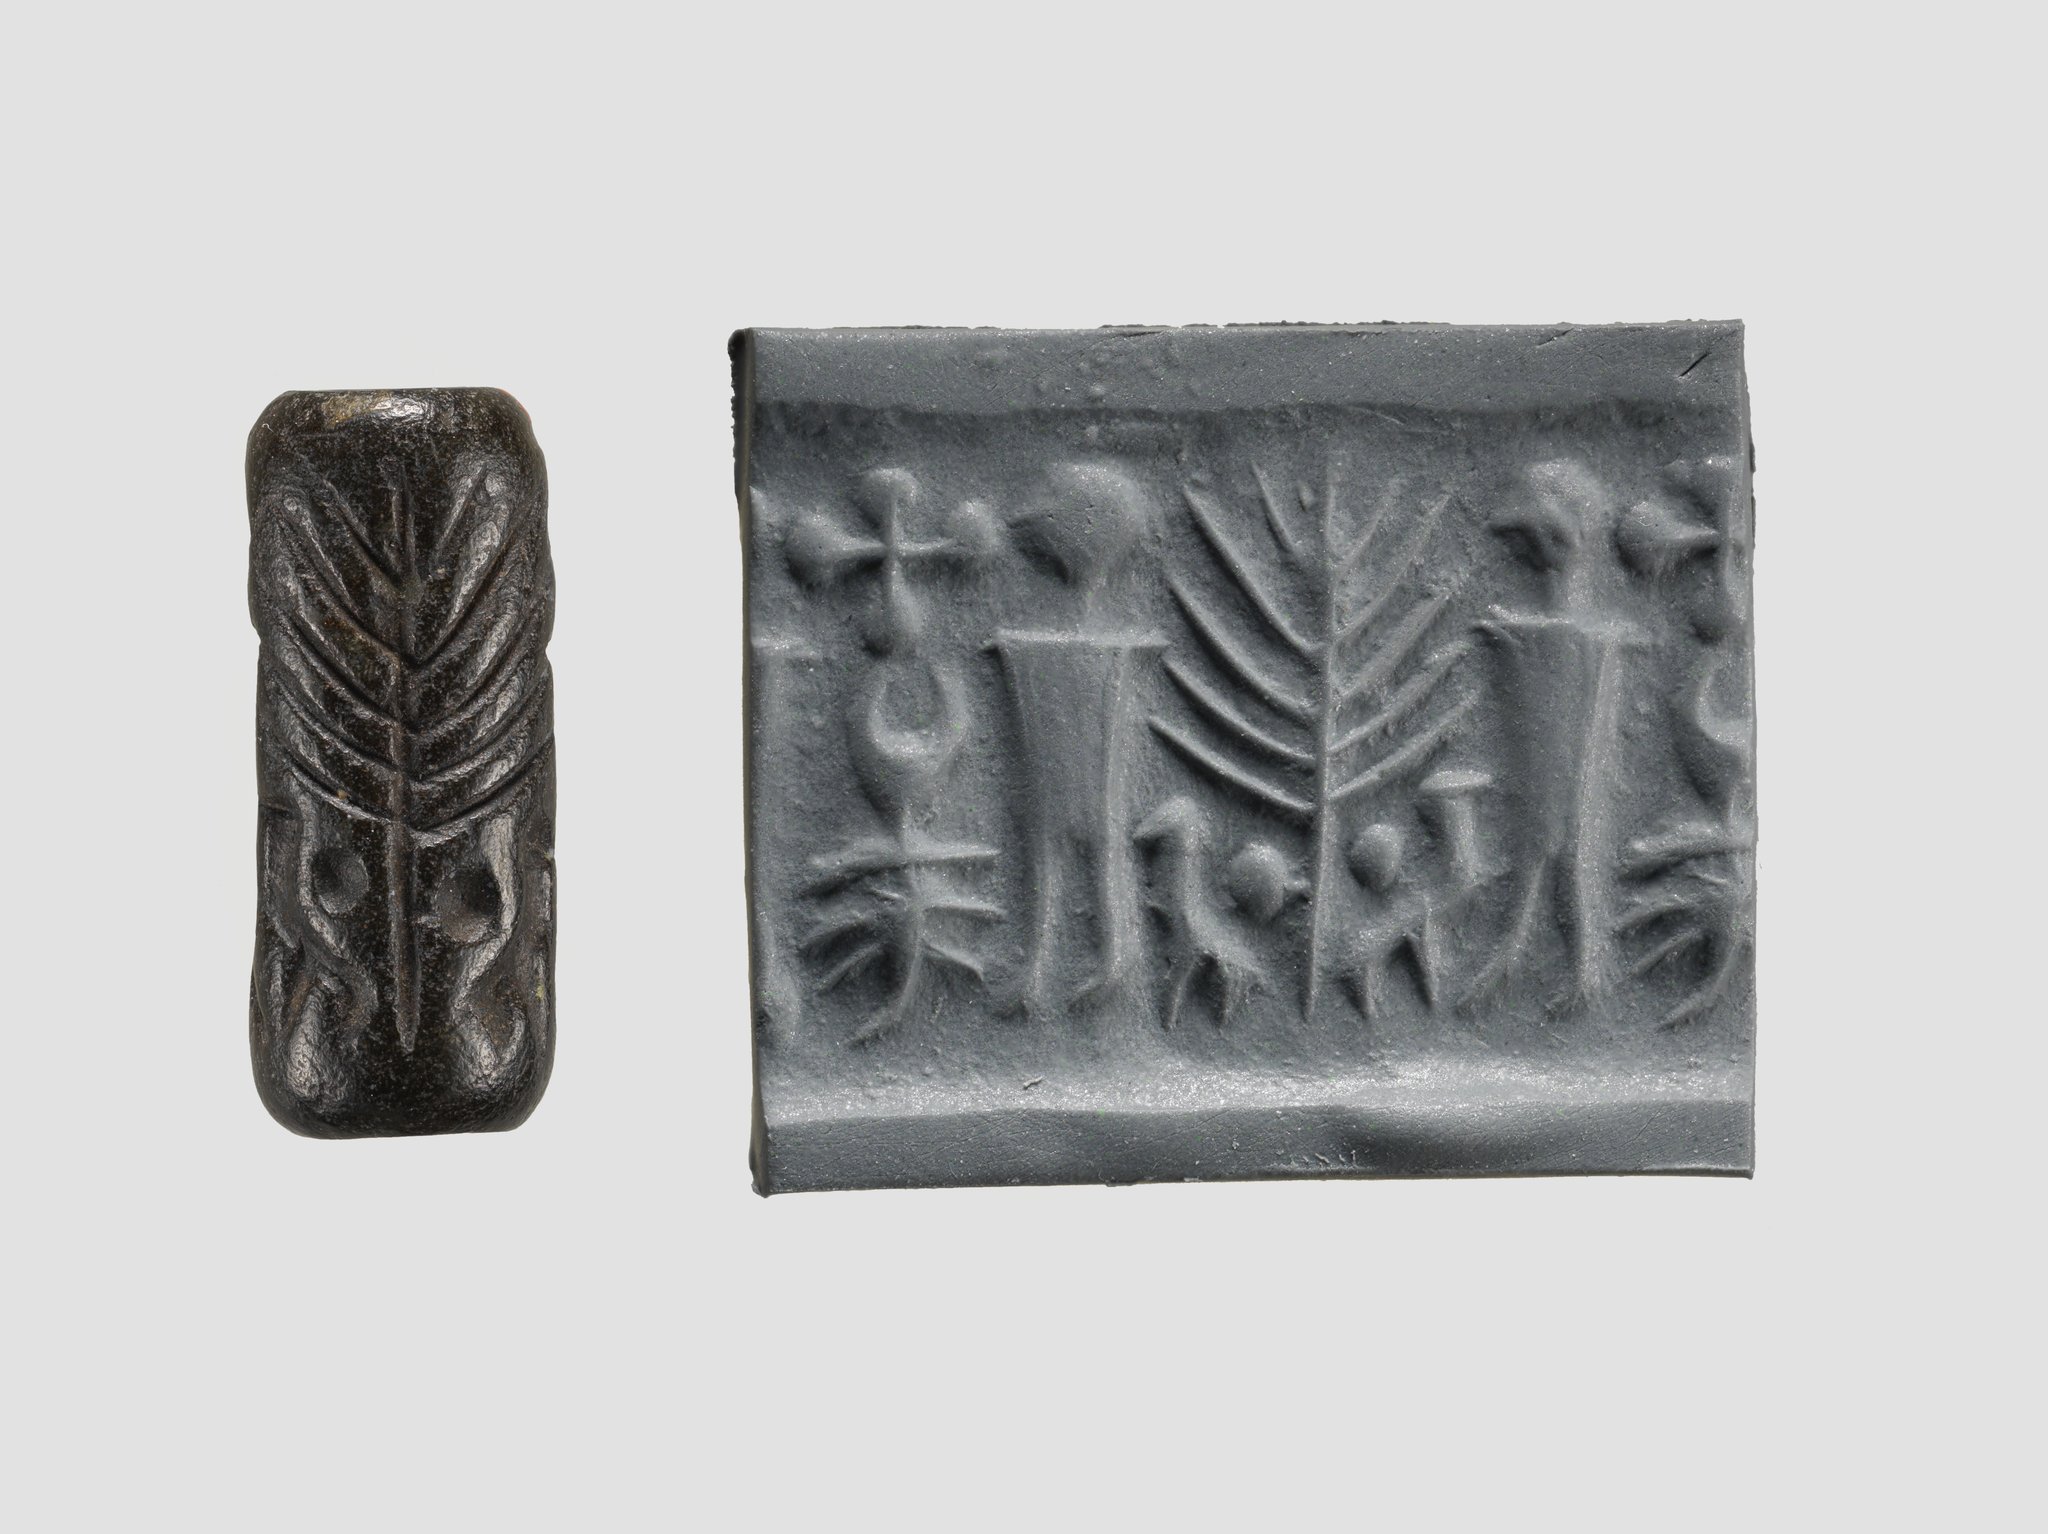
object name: cylinder seal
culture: cypriot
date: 1500-1101 BCE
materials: stone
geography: cyprus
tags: scorpions,lions,trees